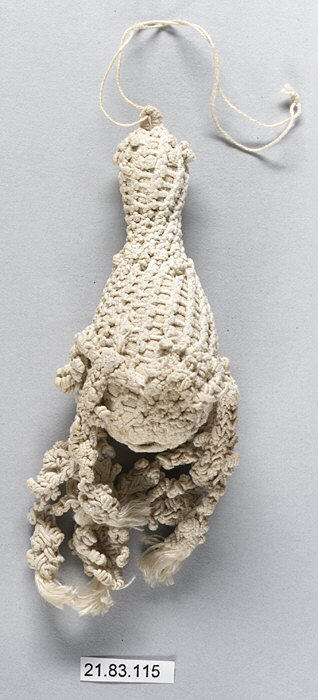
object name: tassel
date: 1601-1700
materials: linen